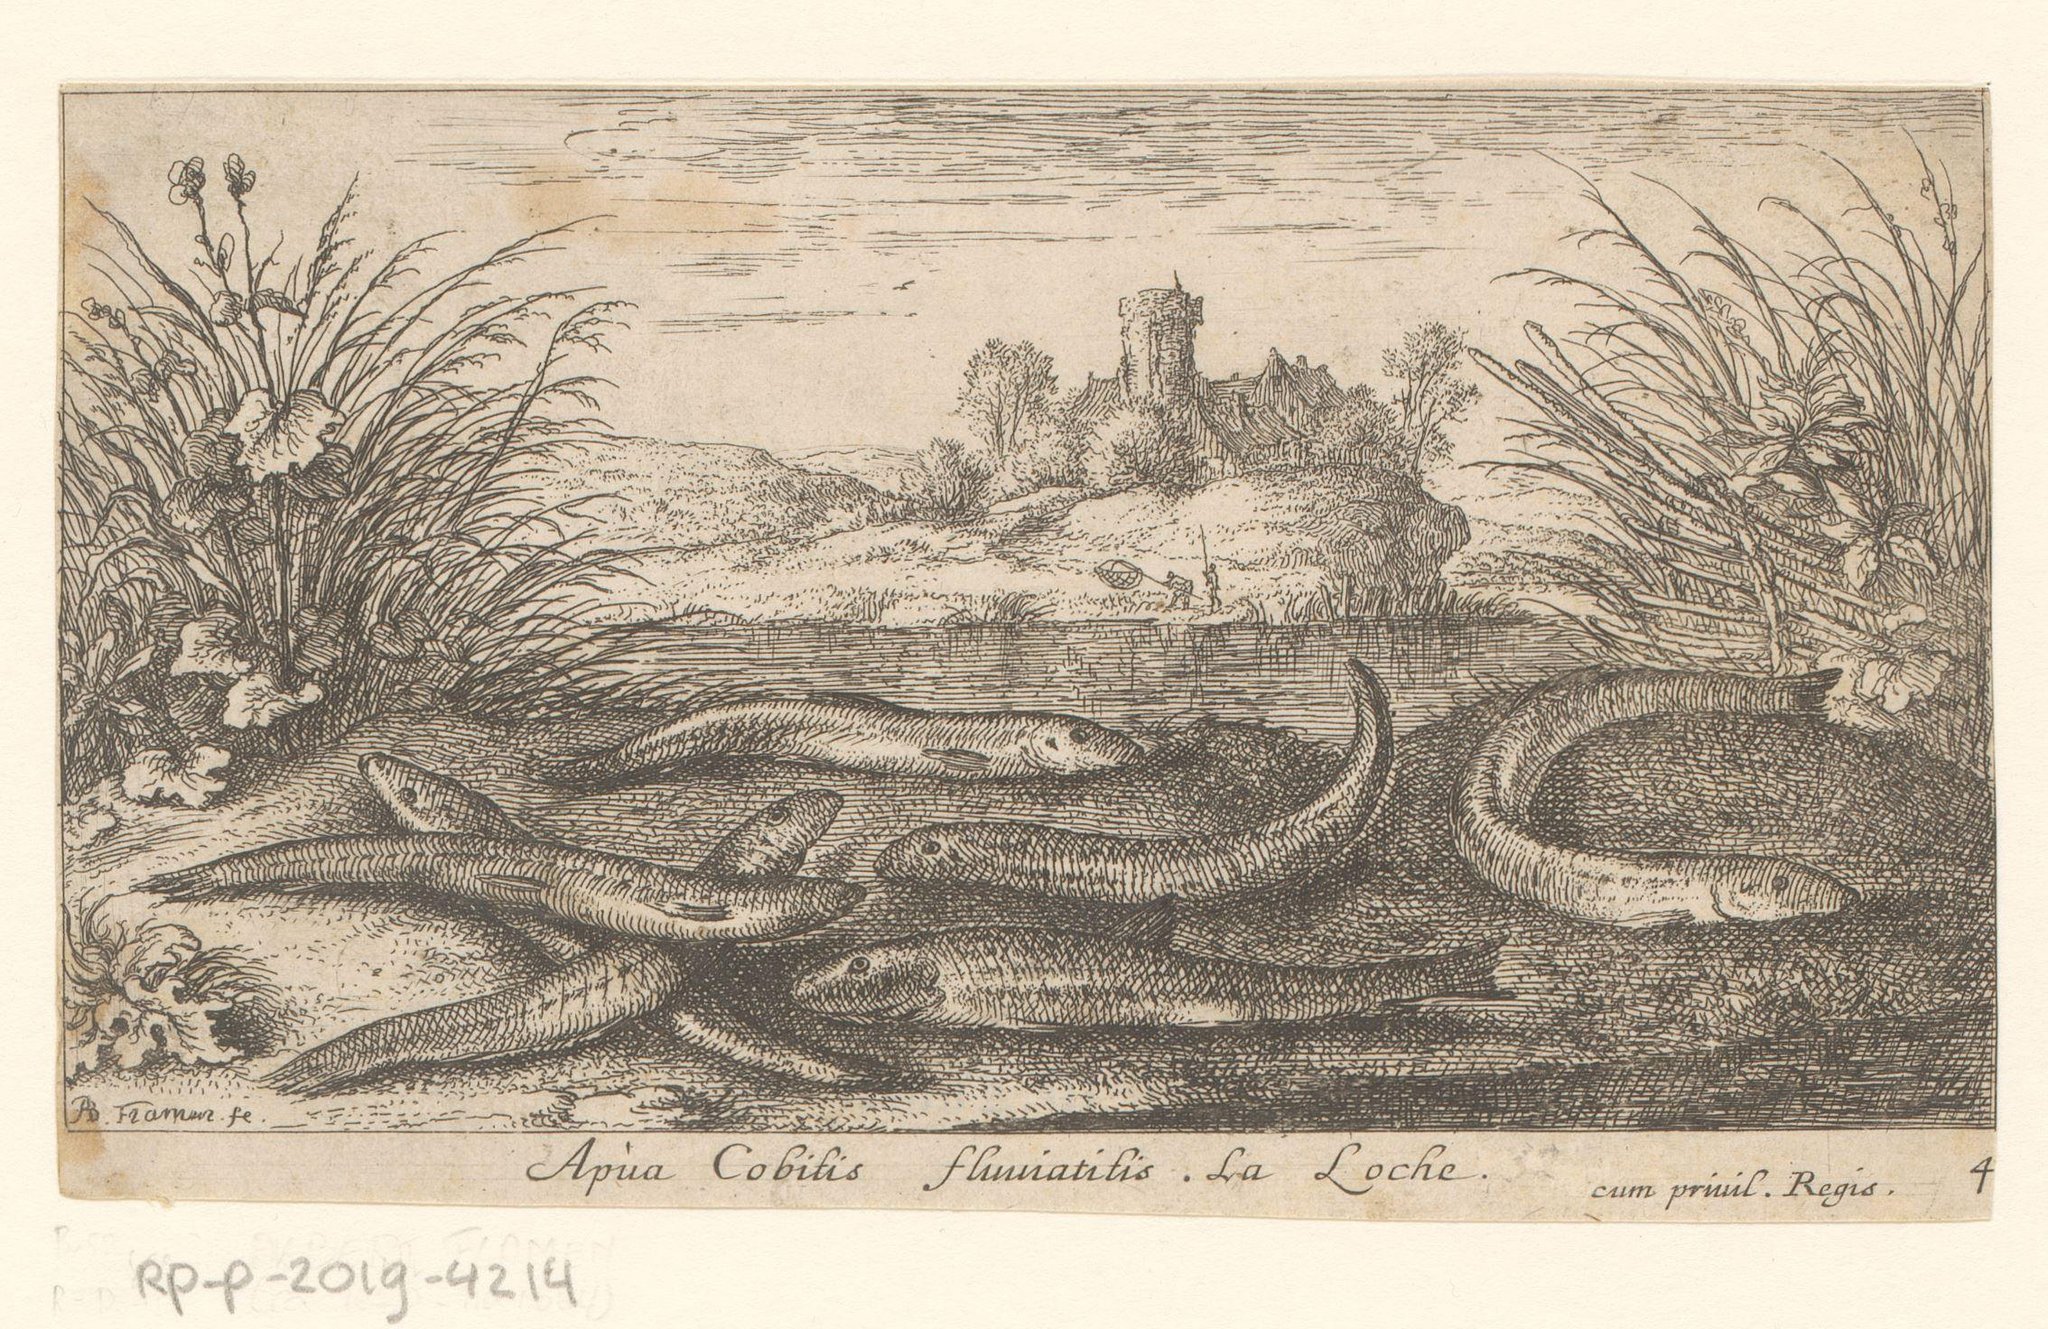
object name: print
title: Apua Cobitis fluvitilis. La Loche.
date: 1664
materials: paper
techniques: etching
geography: paris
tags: fishes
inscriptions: collector's mark: Lugt 1697